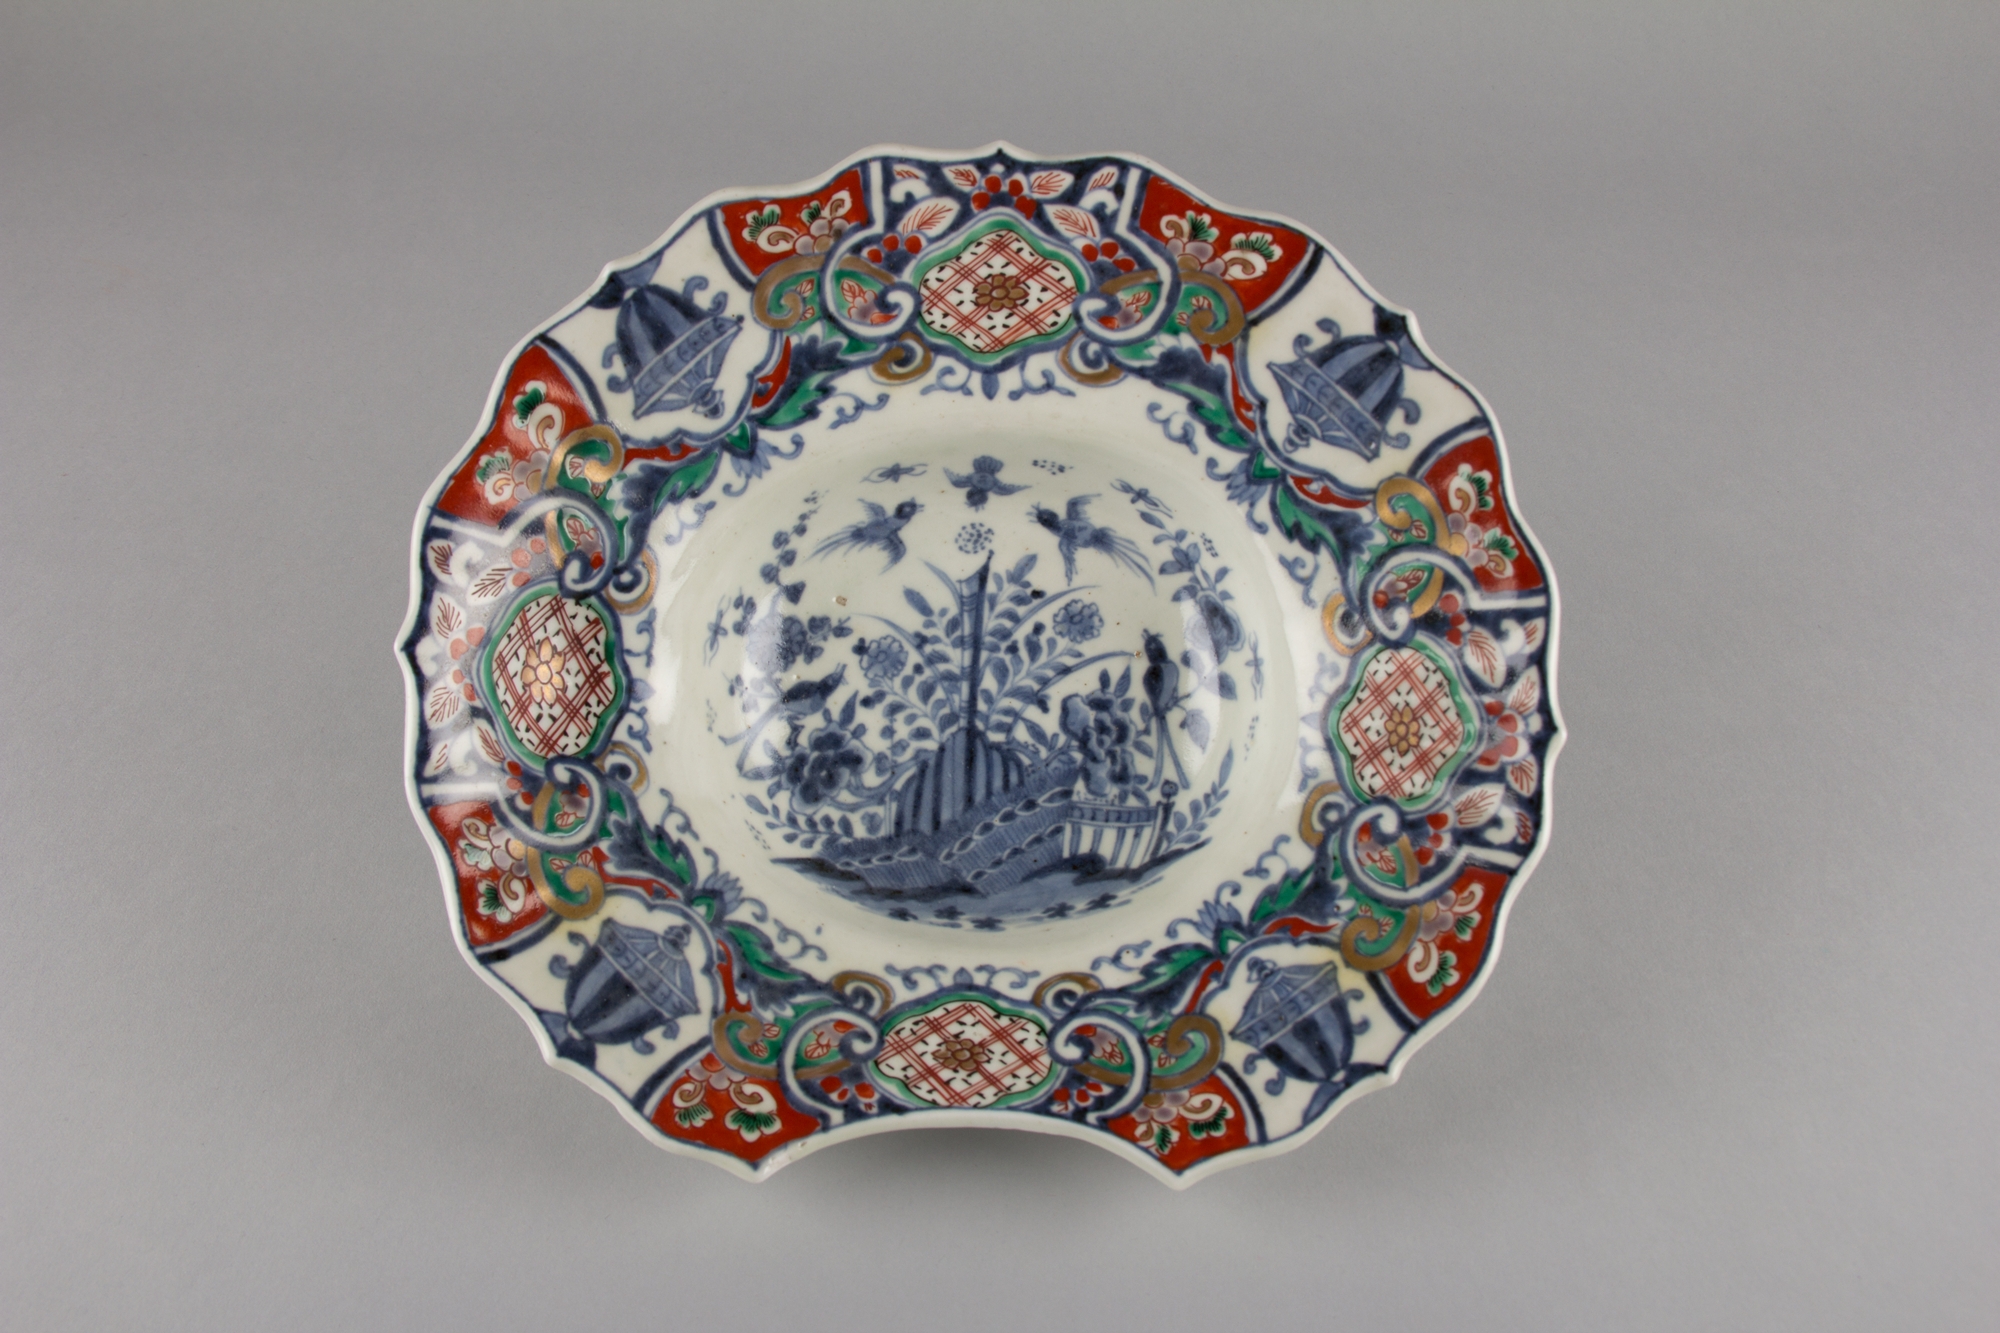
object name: barber's bowl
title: Barber's Bowl with Baroque Decorations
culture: japanese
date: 1667-1733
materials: enamel, gold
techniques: overglaze, underglaze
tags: birds,flowers,leaves